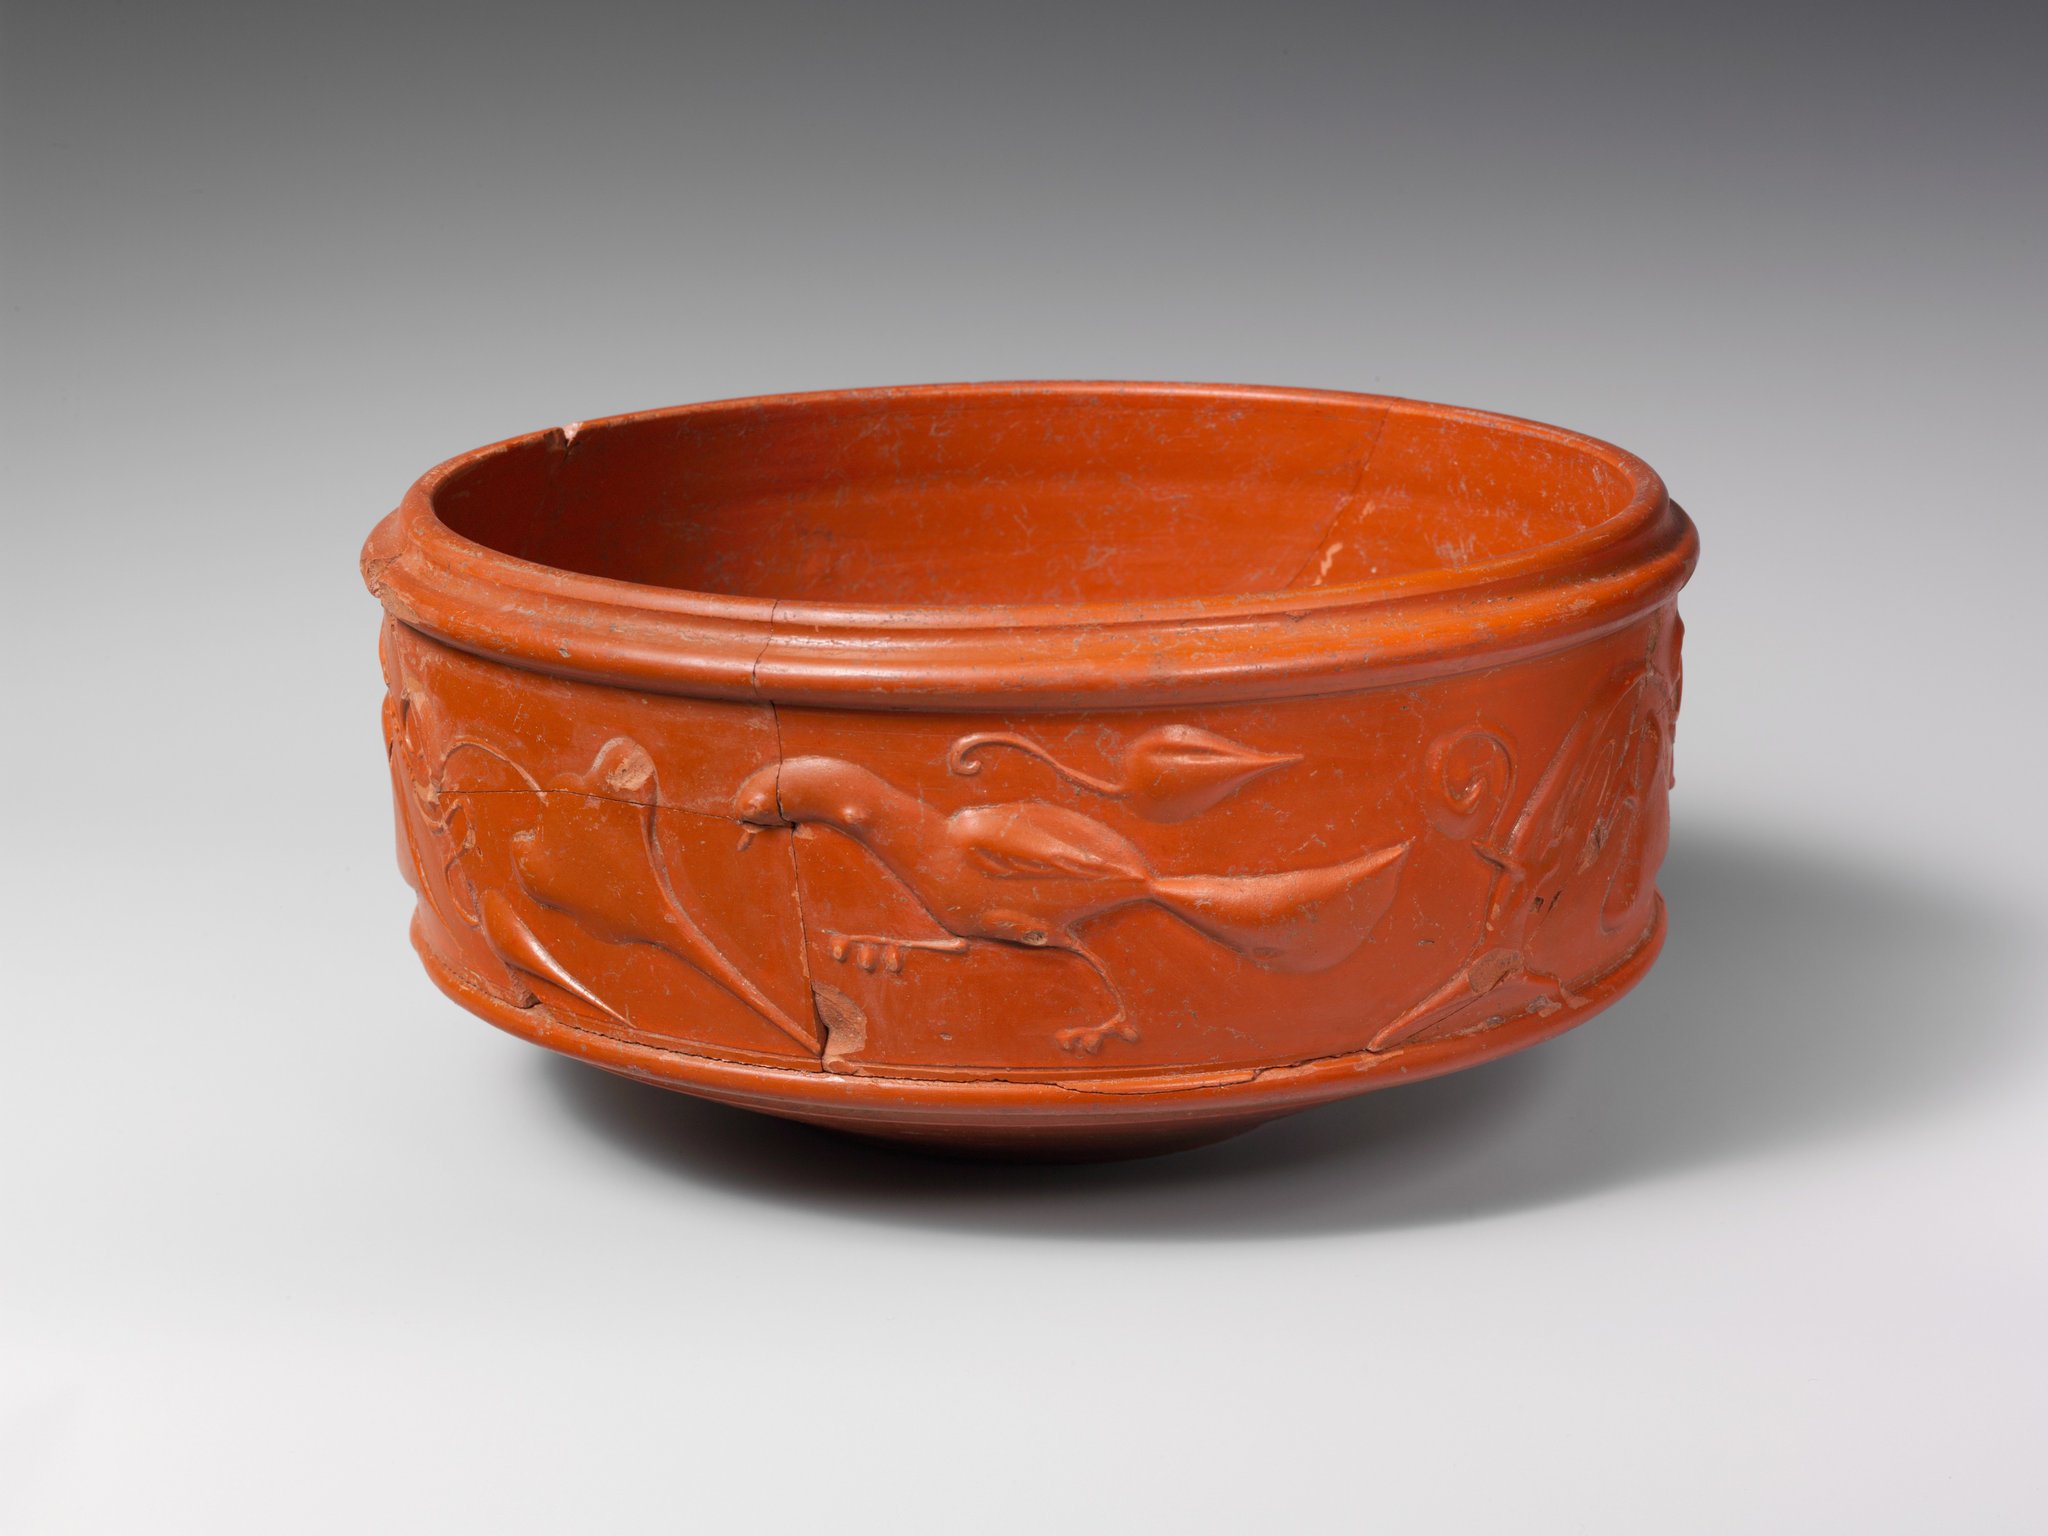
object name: bowl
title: Terracotta dish with barbotine decoration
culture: roman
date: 167-200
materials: terracotta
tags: birds